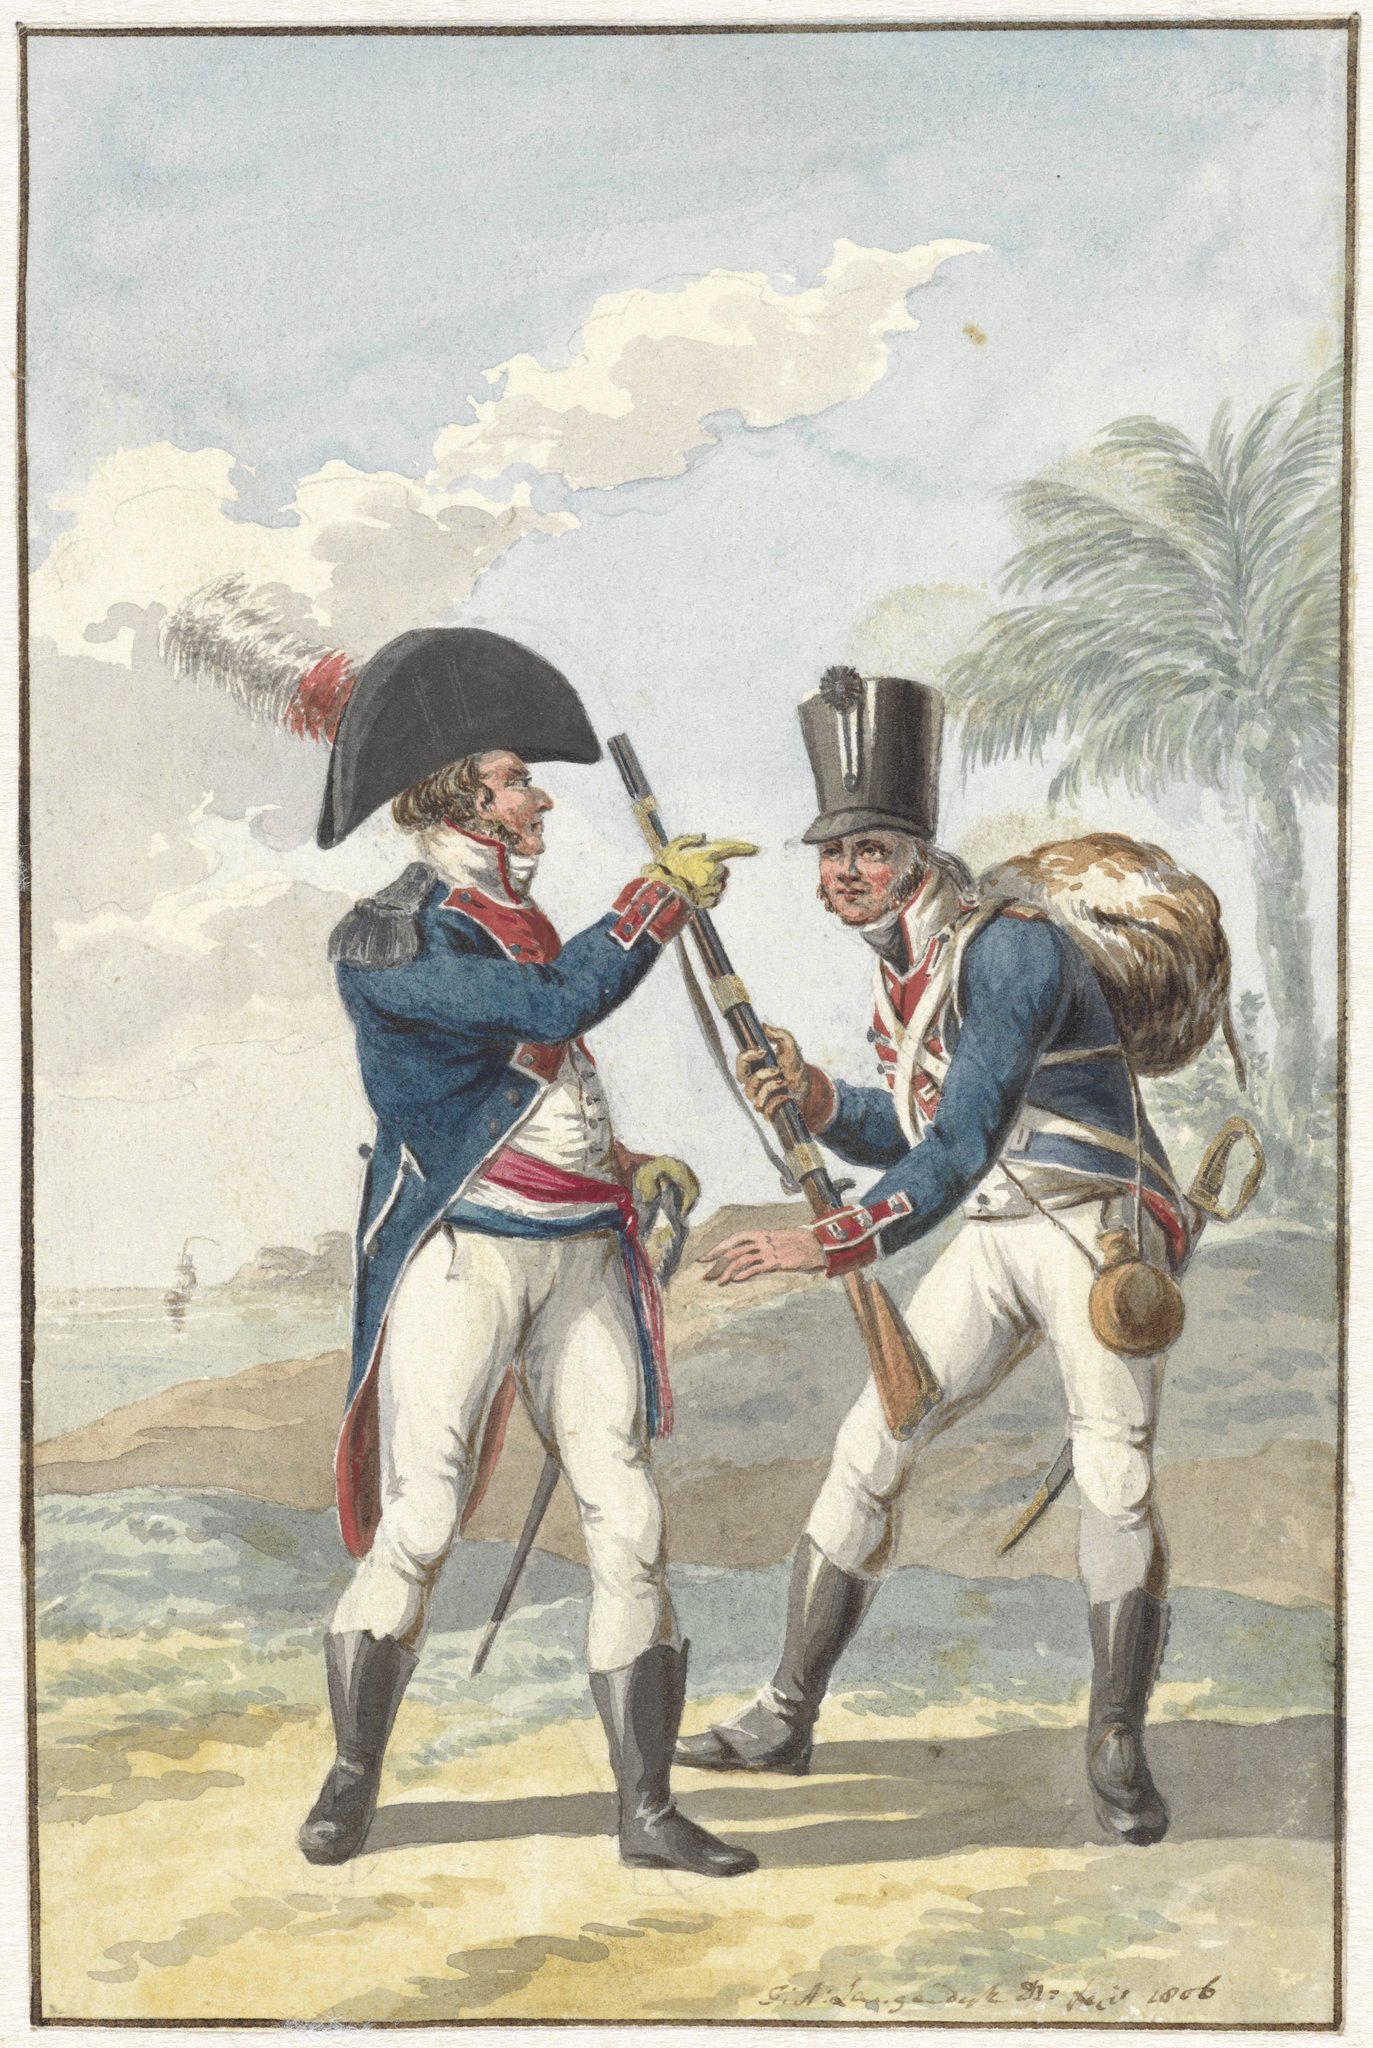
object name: drawing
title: Bataafsche Coloniale Infanterie van de Kaap de Goede Hoop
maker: jan anthonie langendijk dzn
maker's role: draughtsman, print maker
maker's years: 1780-1818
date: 1806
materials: paint, paper, pencil, watercolor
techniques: brush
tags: (military) uniforms, cape of good hope